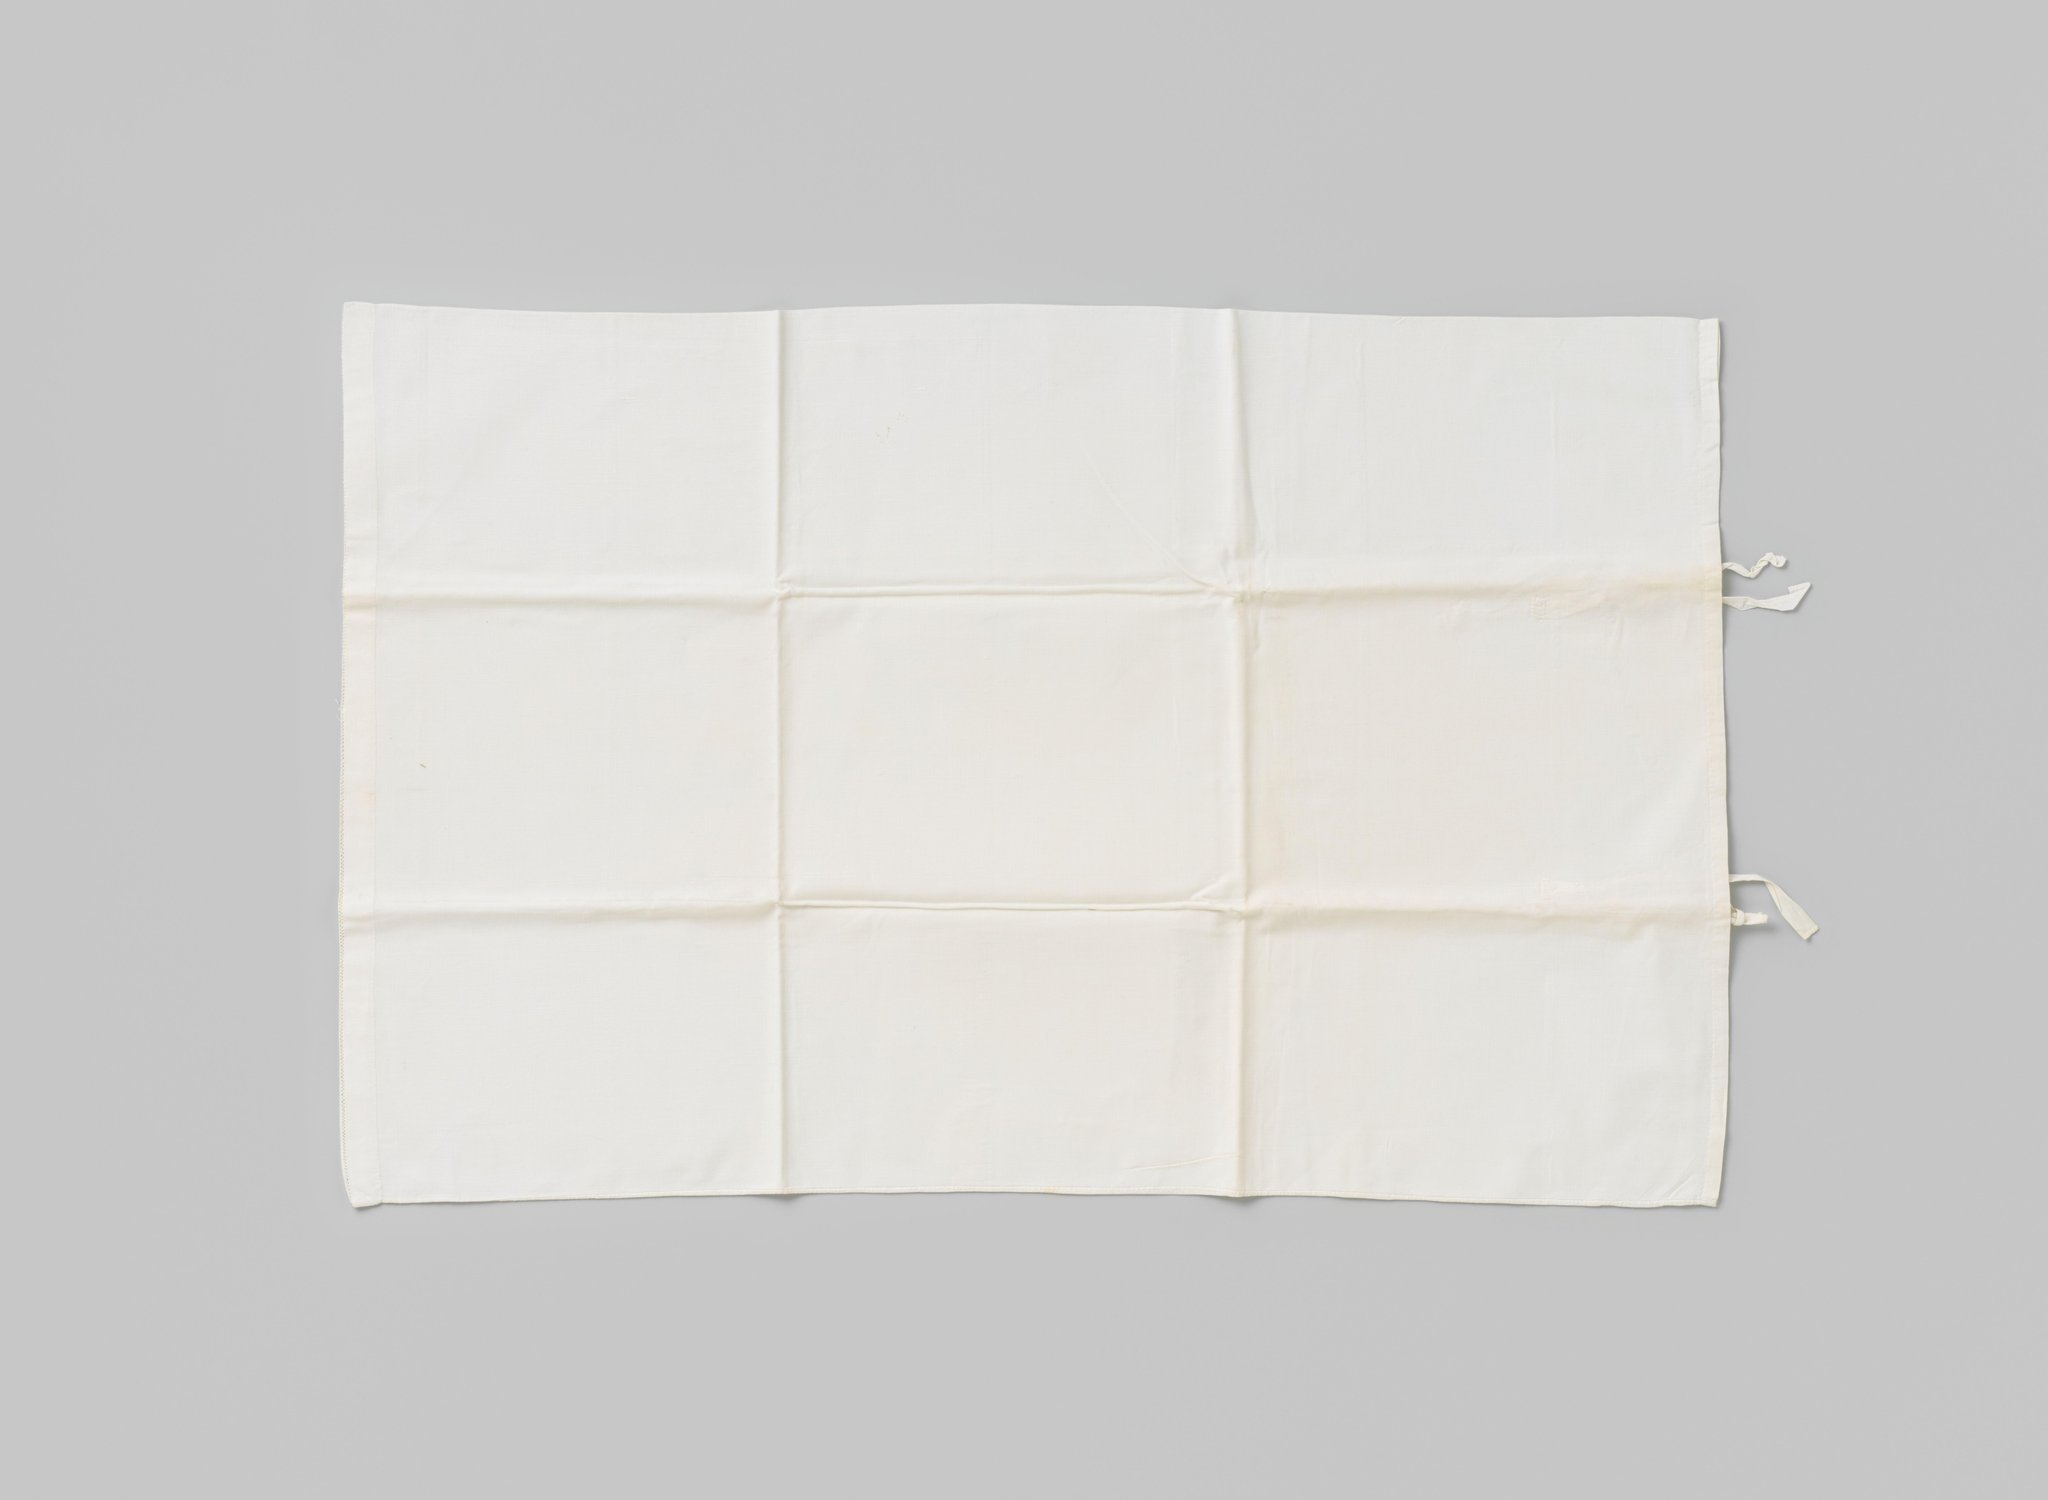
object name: textile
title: Sloop van witte katoen met geborduurde siernaad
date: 1850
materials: cotton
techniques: embroidered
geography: netherlands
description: Sloop van witte katoen met geborduurde siernaad.